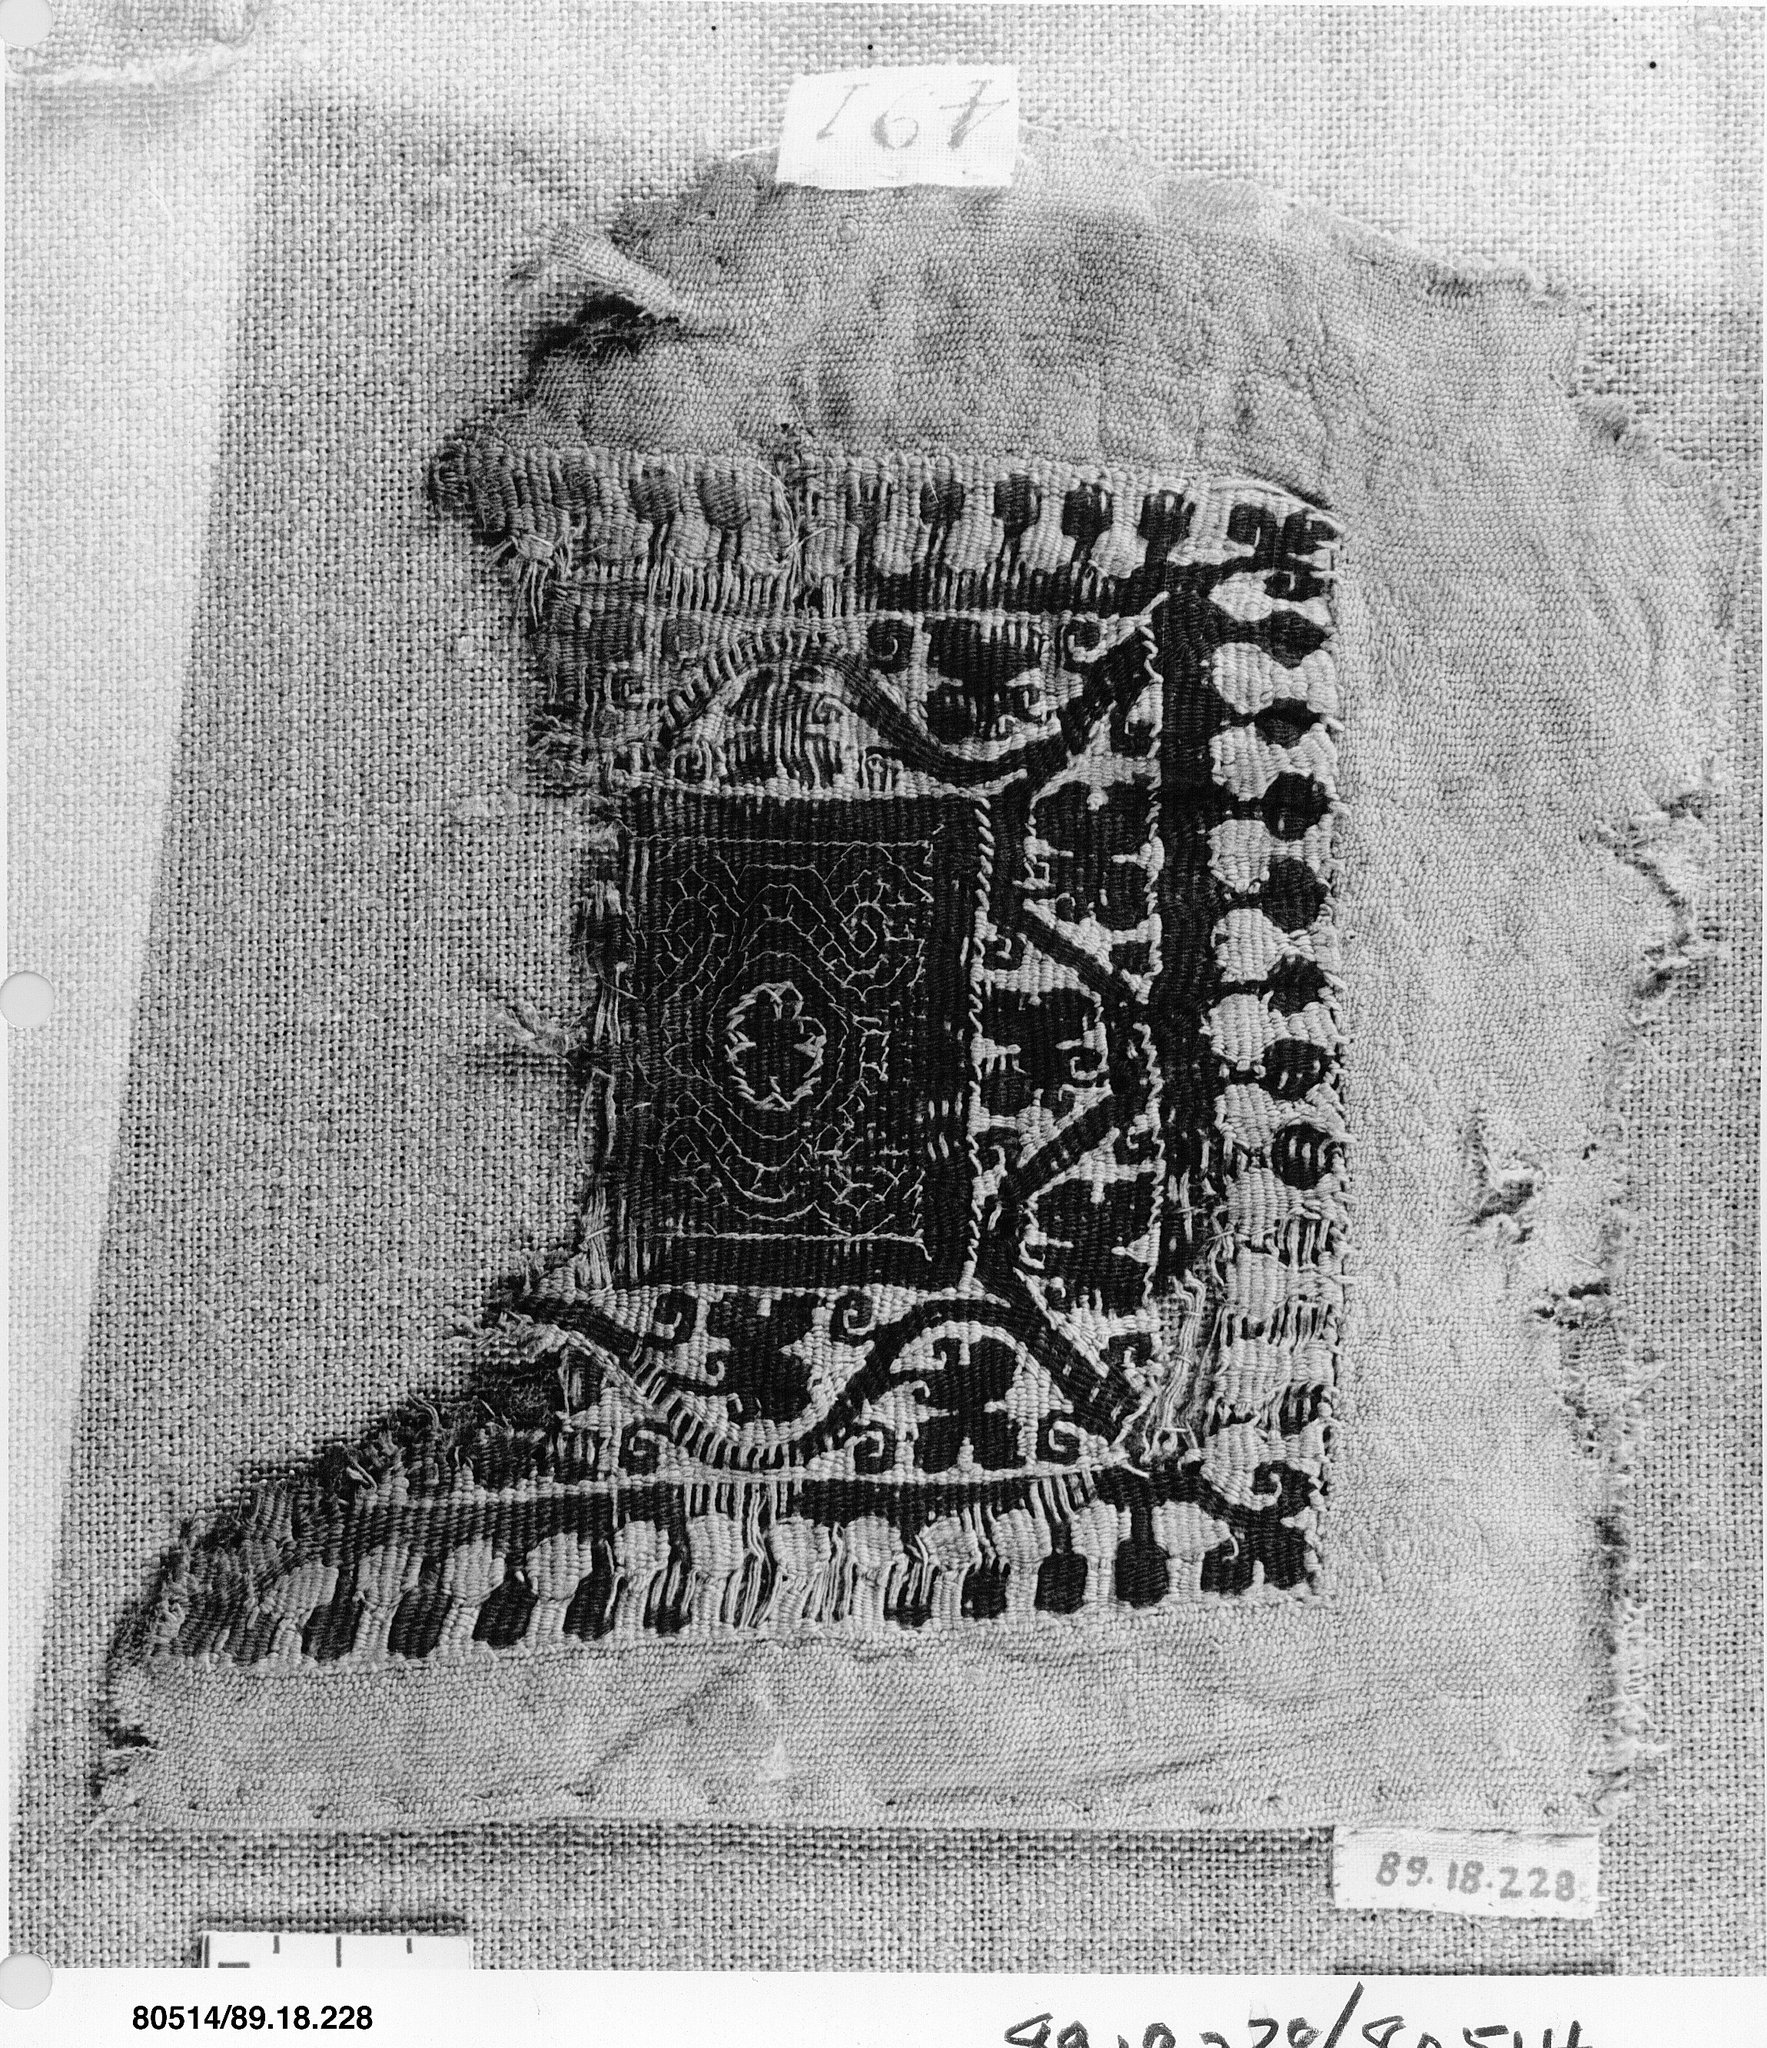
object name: textile fragment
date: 201-400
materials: linen, wool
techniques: weave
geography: egypt